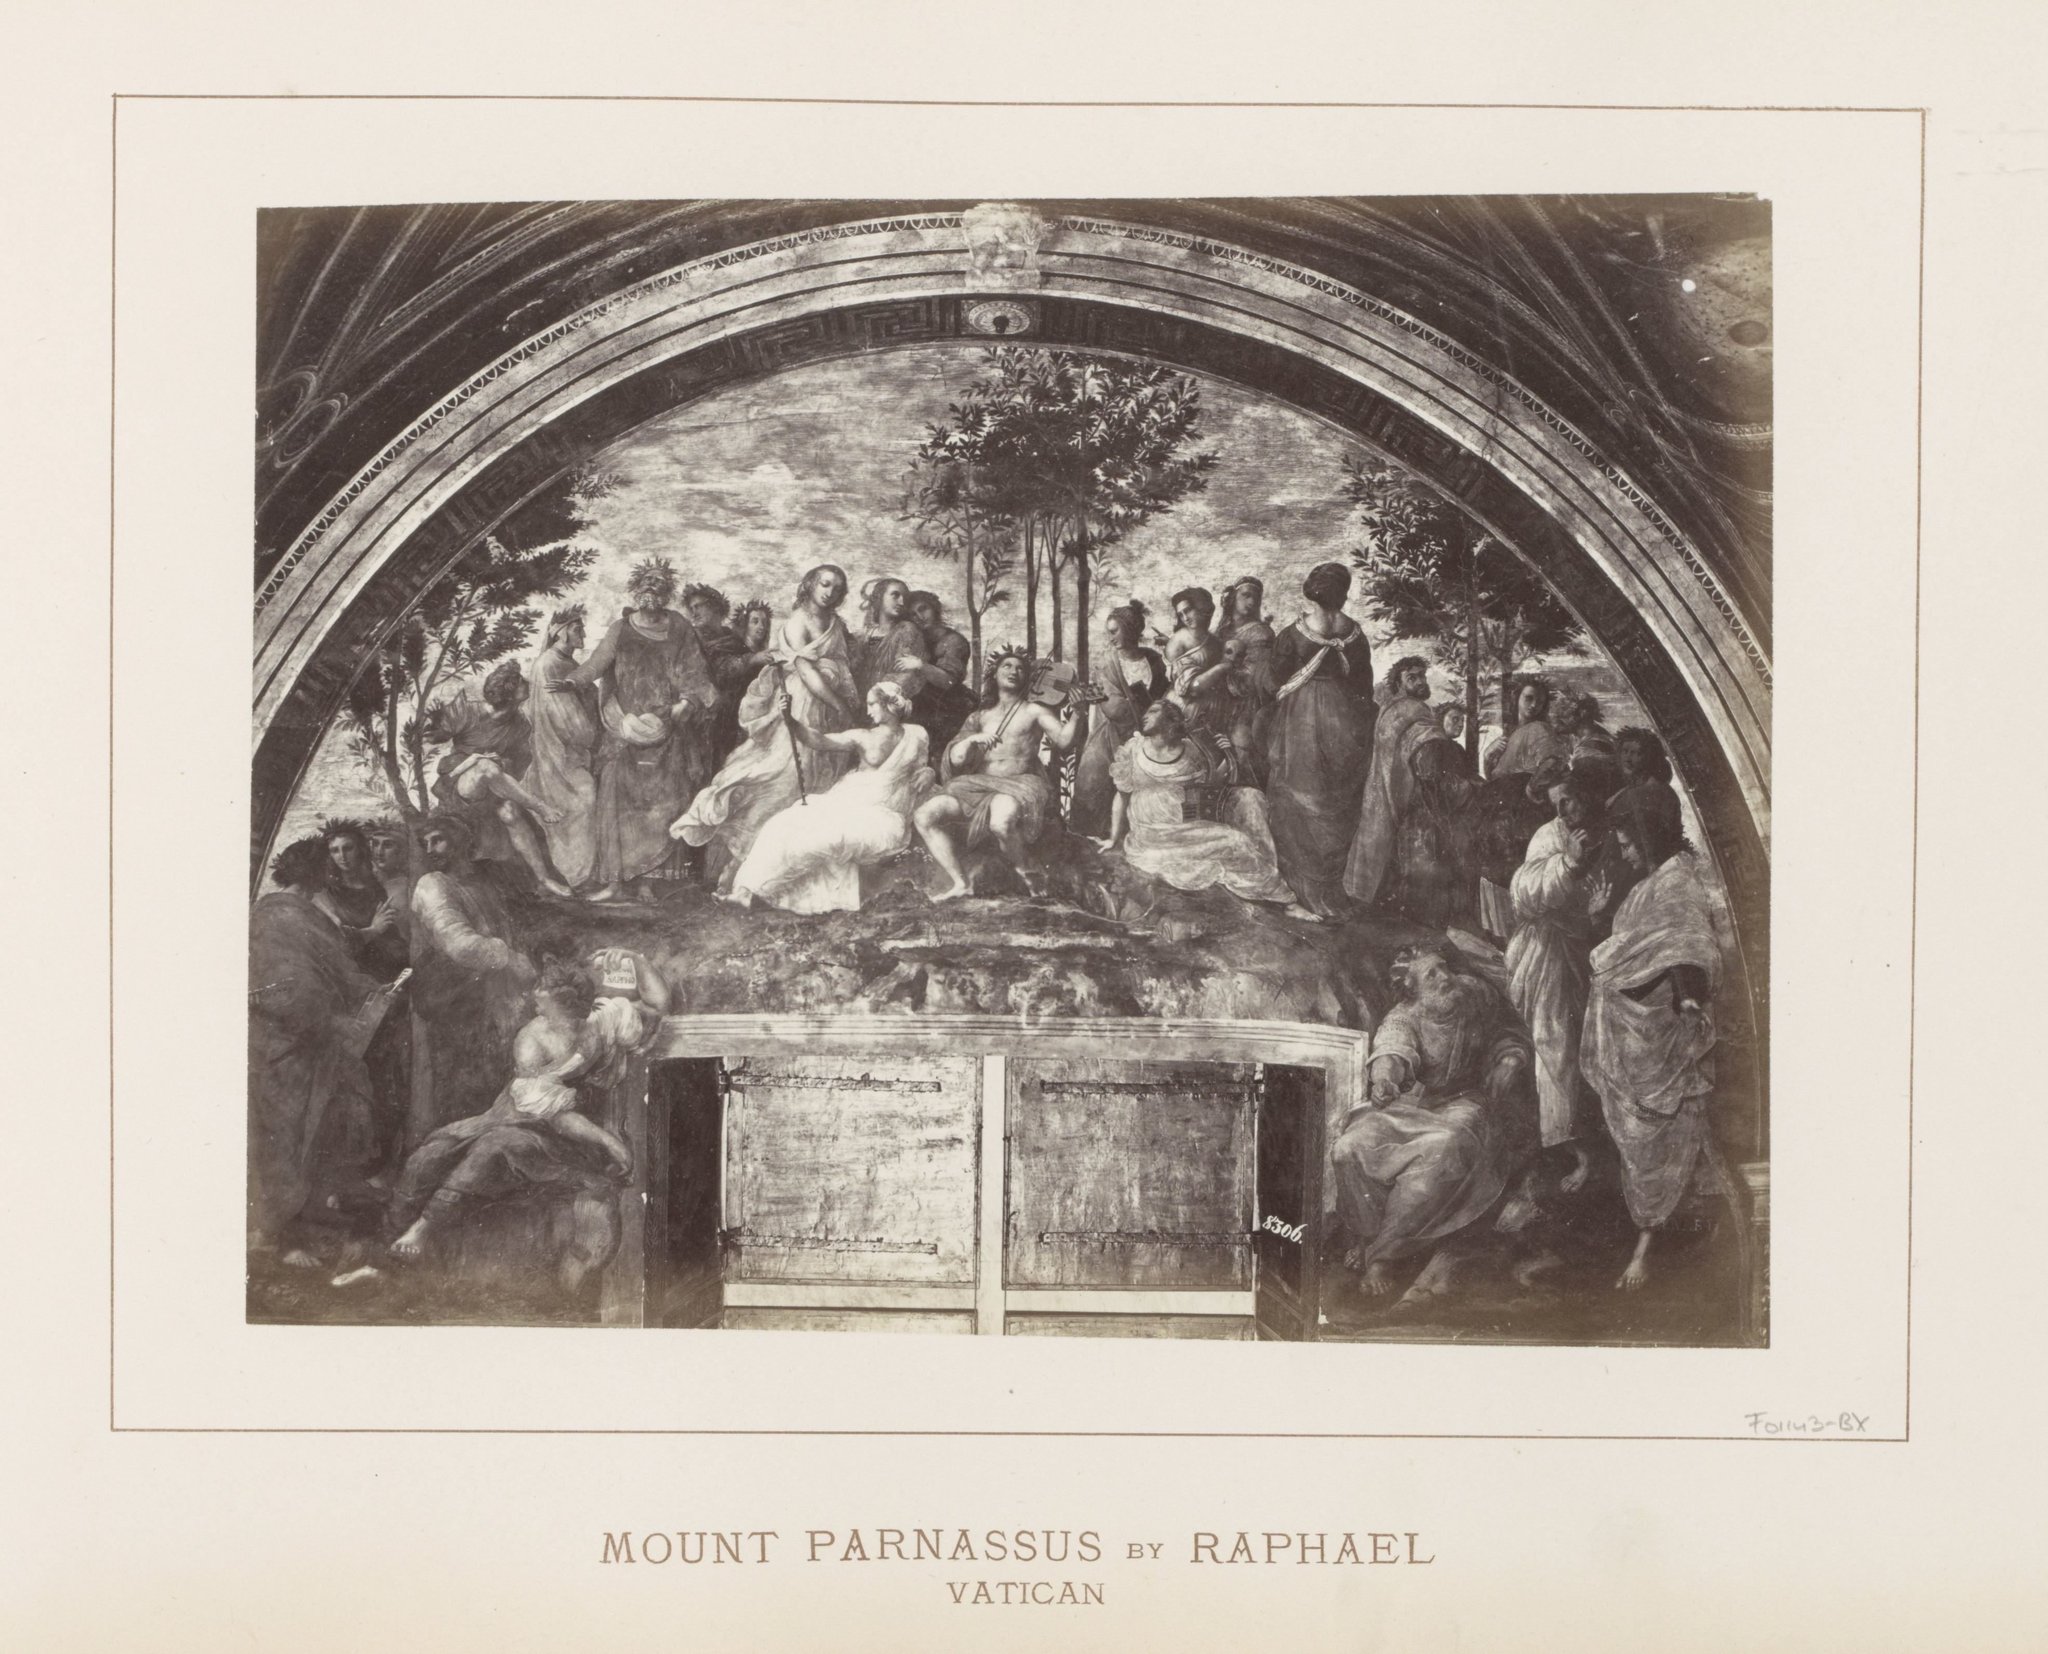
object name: photograph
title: Mount Parnassus by Raphael, Vatican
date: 1860-1900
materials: photographic support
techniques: albumen print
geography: apostolisch paleis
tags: (story of) apollo (phoebus), parnassus, sacred to apollo musagetes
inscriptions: inscription: ‘Alinari’, number: ‘8306’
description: Onderdeel van Fotoalbum met opnames van bezienswaardigheden en kunstwerken in Rome.